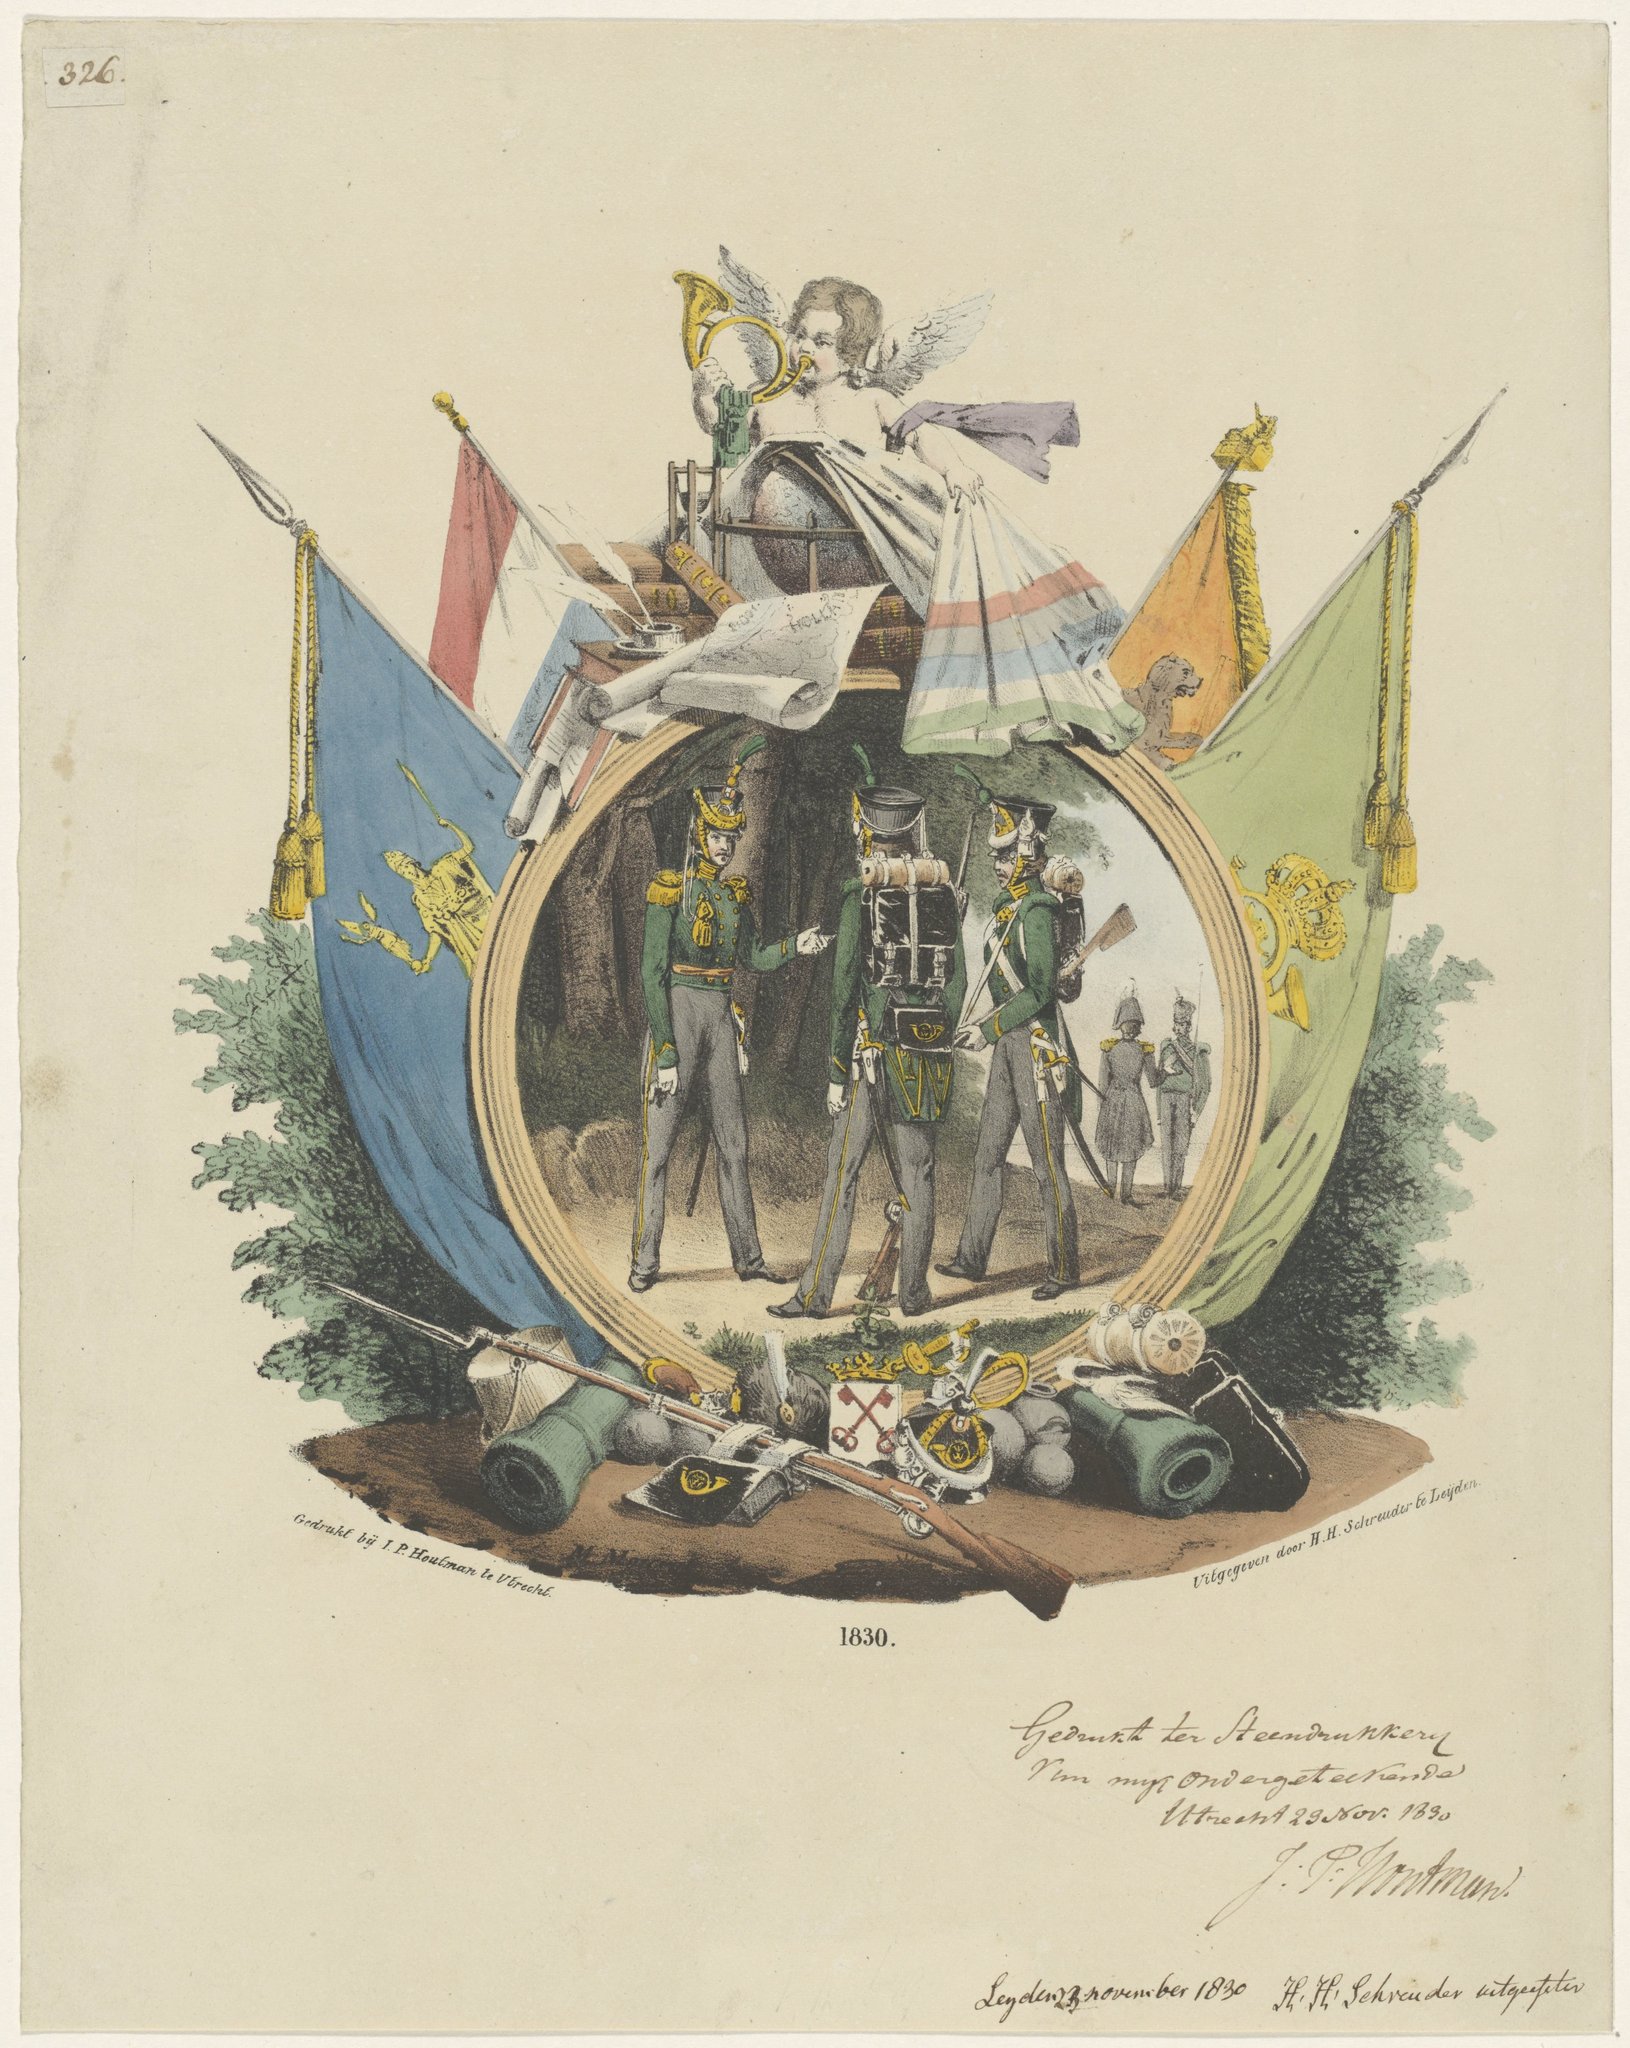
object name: print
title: Medaillon met Vrijwillige Jagers der Leidse Hogeschool, 1830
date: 1830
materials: paper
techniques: hand coloring, lithograph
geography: netherlands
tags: (military) uniforms, clothes, costume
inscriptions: inscription: ‘Gedrukt ter Steendrukkerij van mij ondergeteekende Utrecht 23 nov. 1830 J: P: Houtman / Leyden 23 november 1830 H.H. Schreuder uitgeefster’, collector's mark: Lugt 2228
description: Allegorisch medaillon met een voorstelling van enkele Vrijwillige Jagers der Leidse Hogeschool, 1830. Op de grond voor het medaillon liggen wapens en delen van de wapenrusting bij het stadswapen van Leiden. Aan weerszijden vaandels, bovenaan attributen van de universitaire studie: boeken, pen en papier, met een putto die op een hoorn blaast. Dit exemplaar met signaturen van drukker en uitgeefster. Zie ook de pendant.